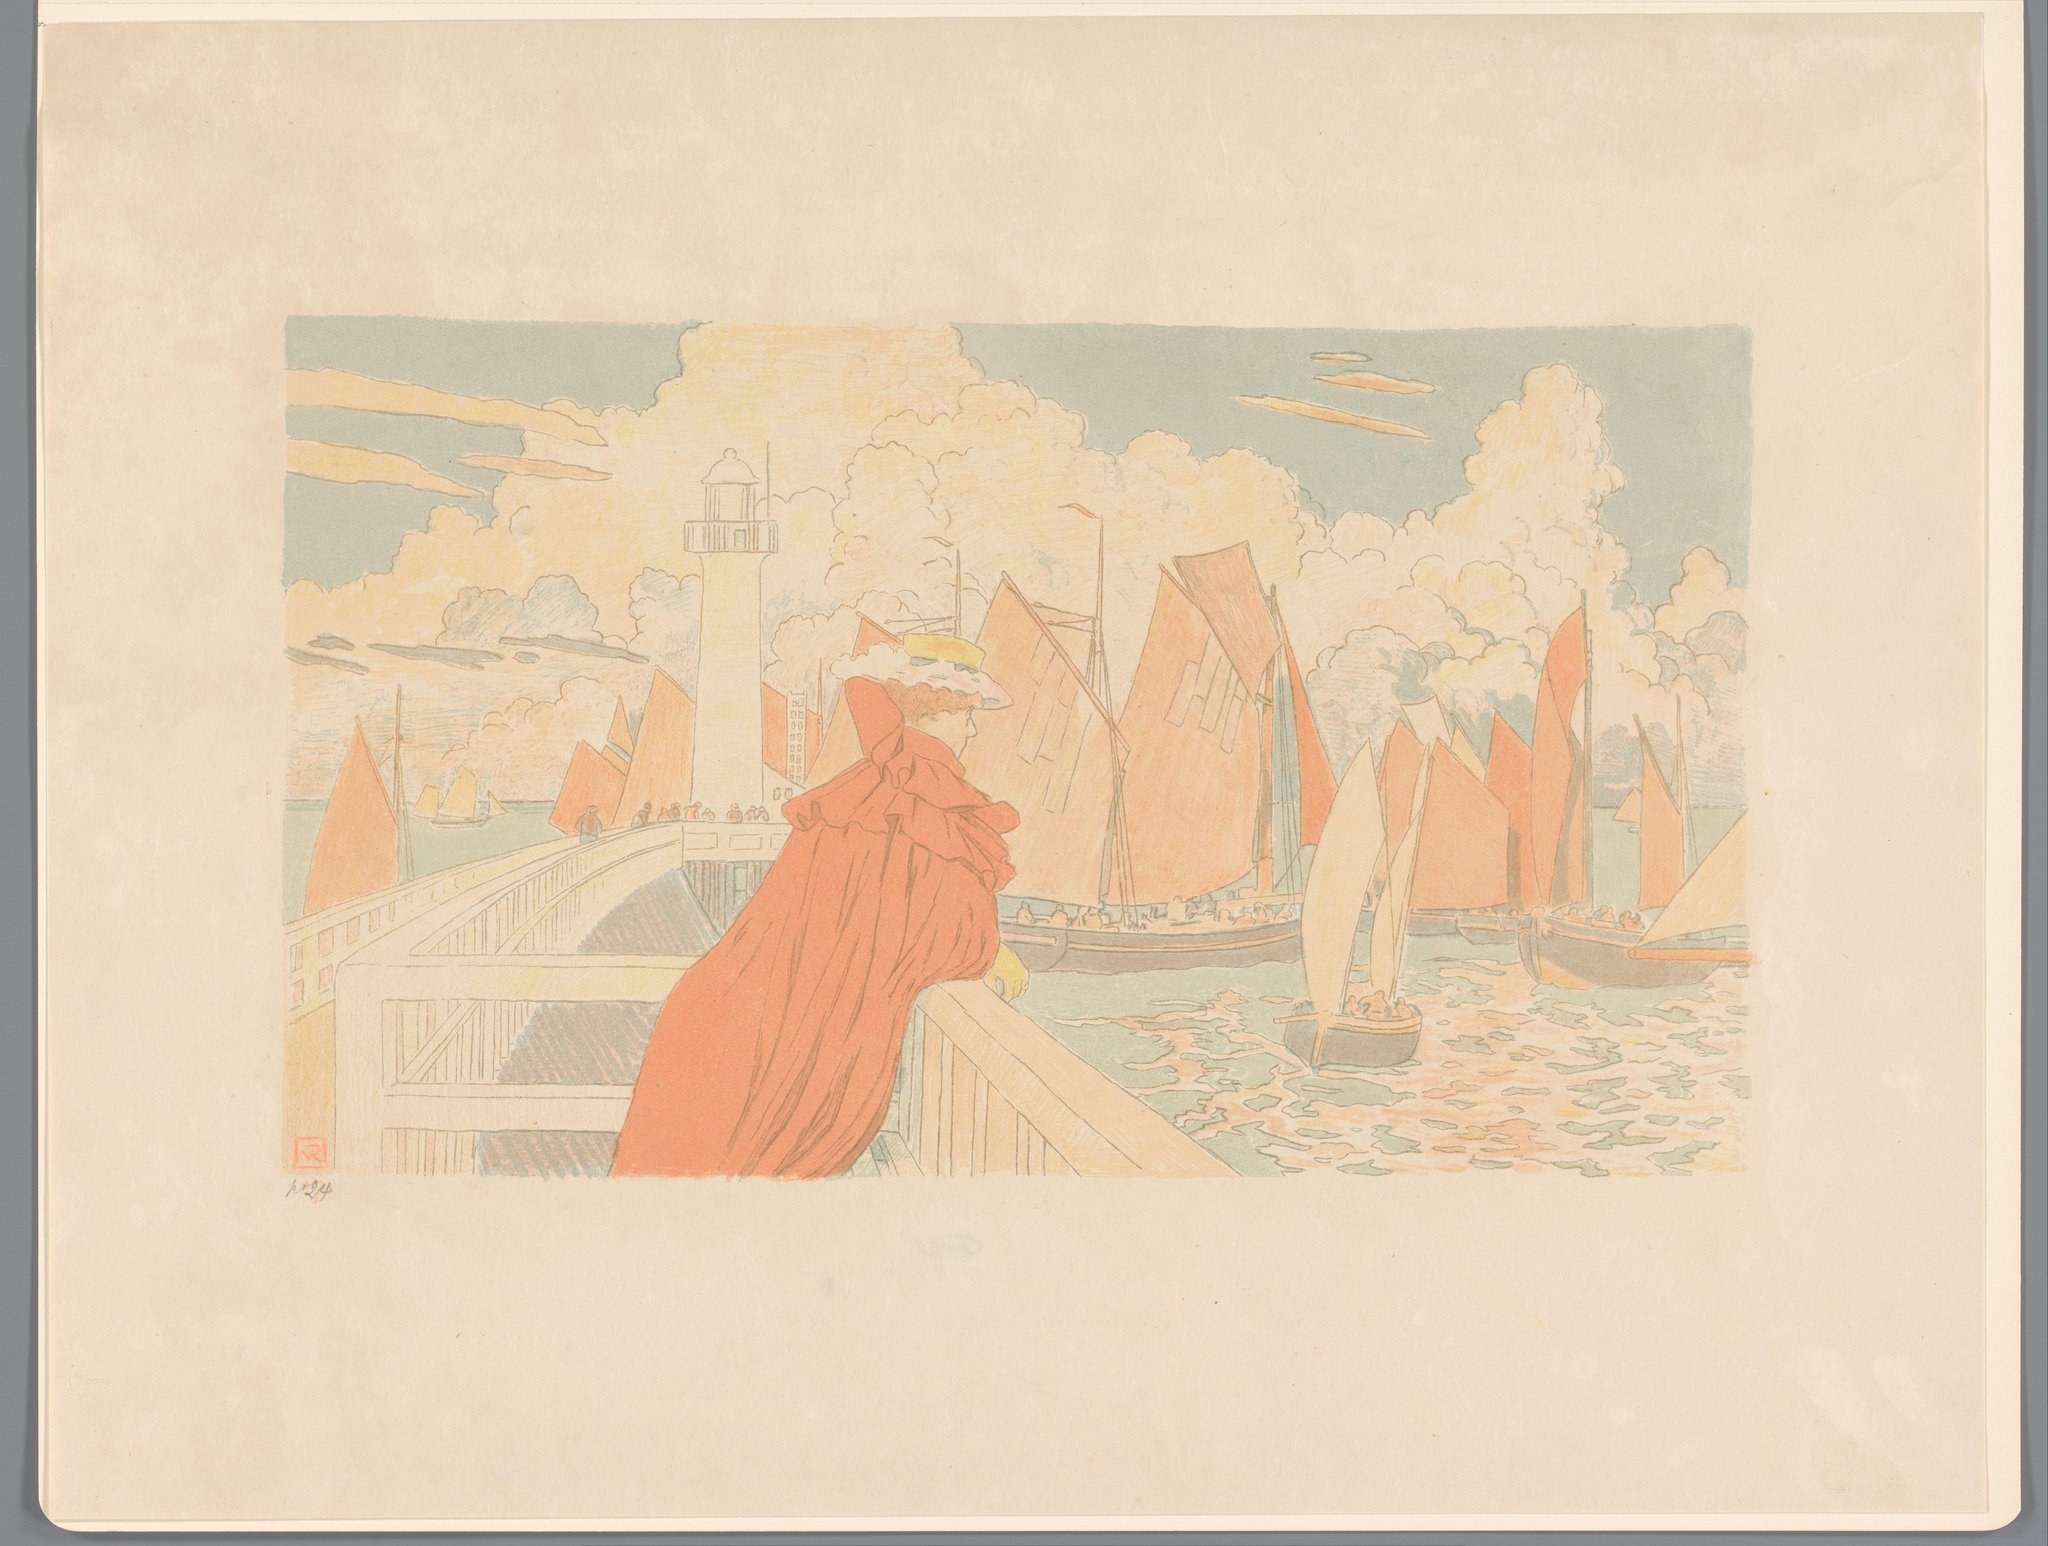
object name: print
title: Vrouw uitkijkend over een haven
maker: theo van rysselberghe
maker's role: draughtsman, print maker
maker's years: 1862-1926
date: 1901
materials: paper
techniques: lithograph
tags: harbour, lighthouse, lightship, sea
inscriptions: collector's mark: Lugt 2228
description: Prent uit: Germinal : album de vingt estampes originales. Parijs: La Maison Moderne, 1901.